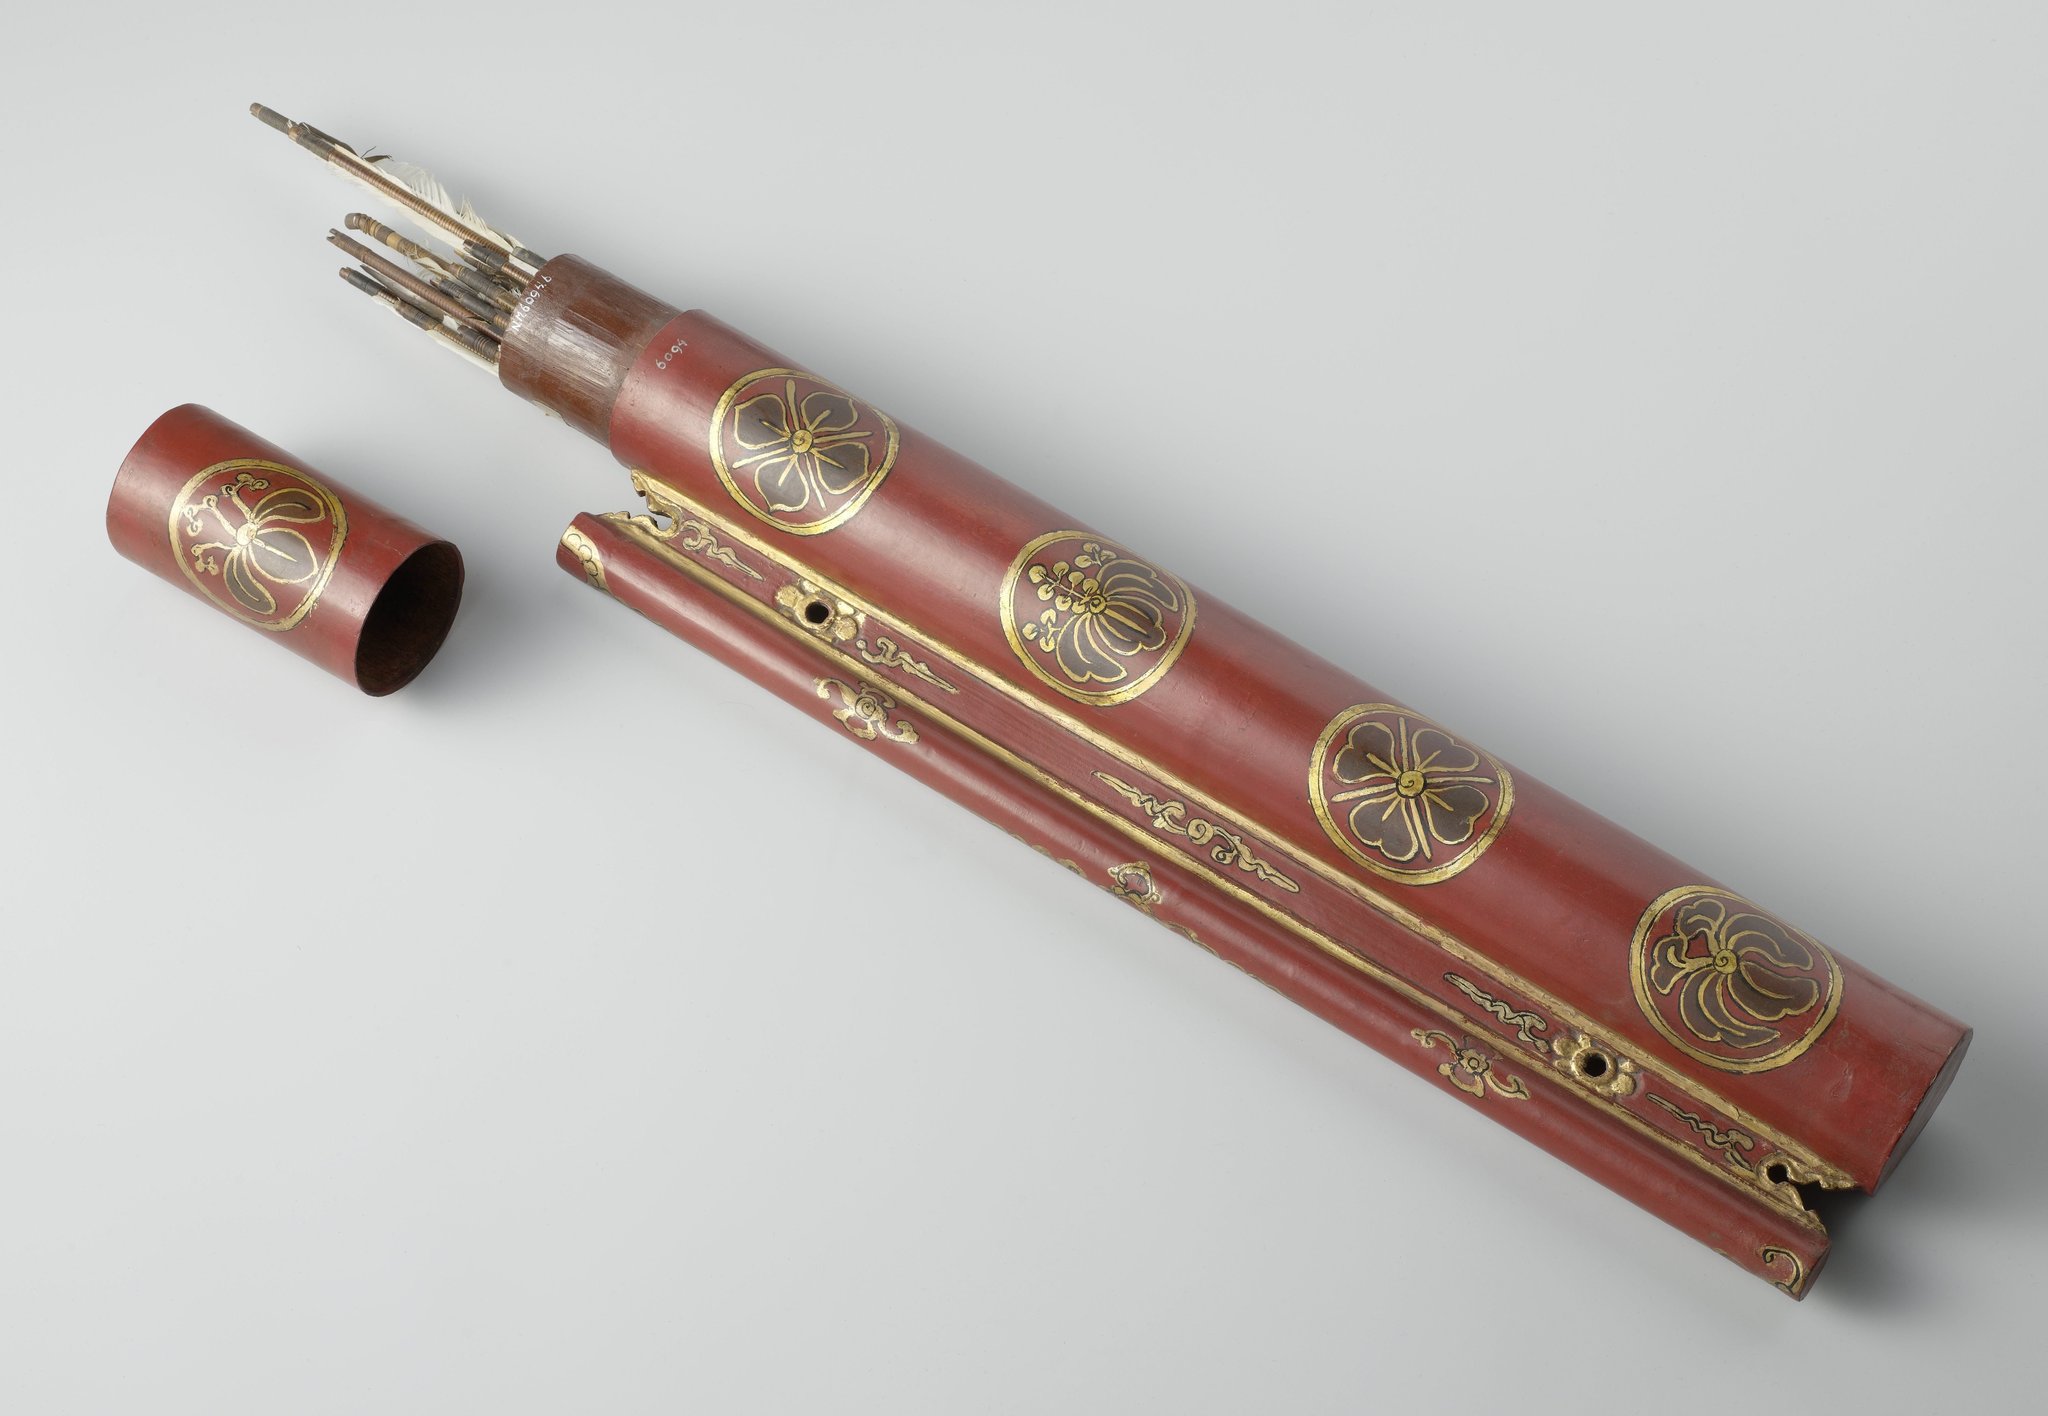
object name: arrow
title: Pijlkoker met 28 pijlen behorend bij wapenrek van Cornelis Tromp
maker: Anonymous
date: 1650-1679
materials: brass, wood, feather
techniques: painted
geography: southeast asia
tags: rotterdam, amsterdam, cornelis tromp, flowers ~ ornament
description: Arms collection of Cornelis Tromp. These weapons were kept at the Amsterdam home of Cornelis Tromp. The collection included contemporary weapons of exceptional quality and several exotic weapons acquired for their curiosity value. Tromp probably received many of these weapons as gifts during his patrols of the Mediterranean Sea and in the Baltic.